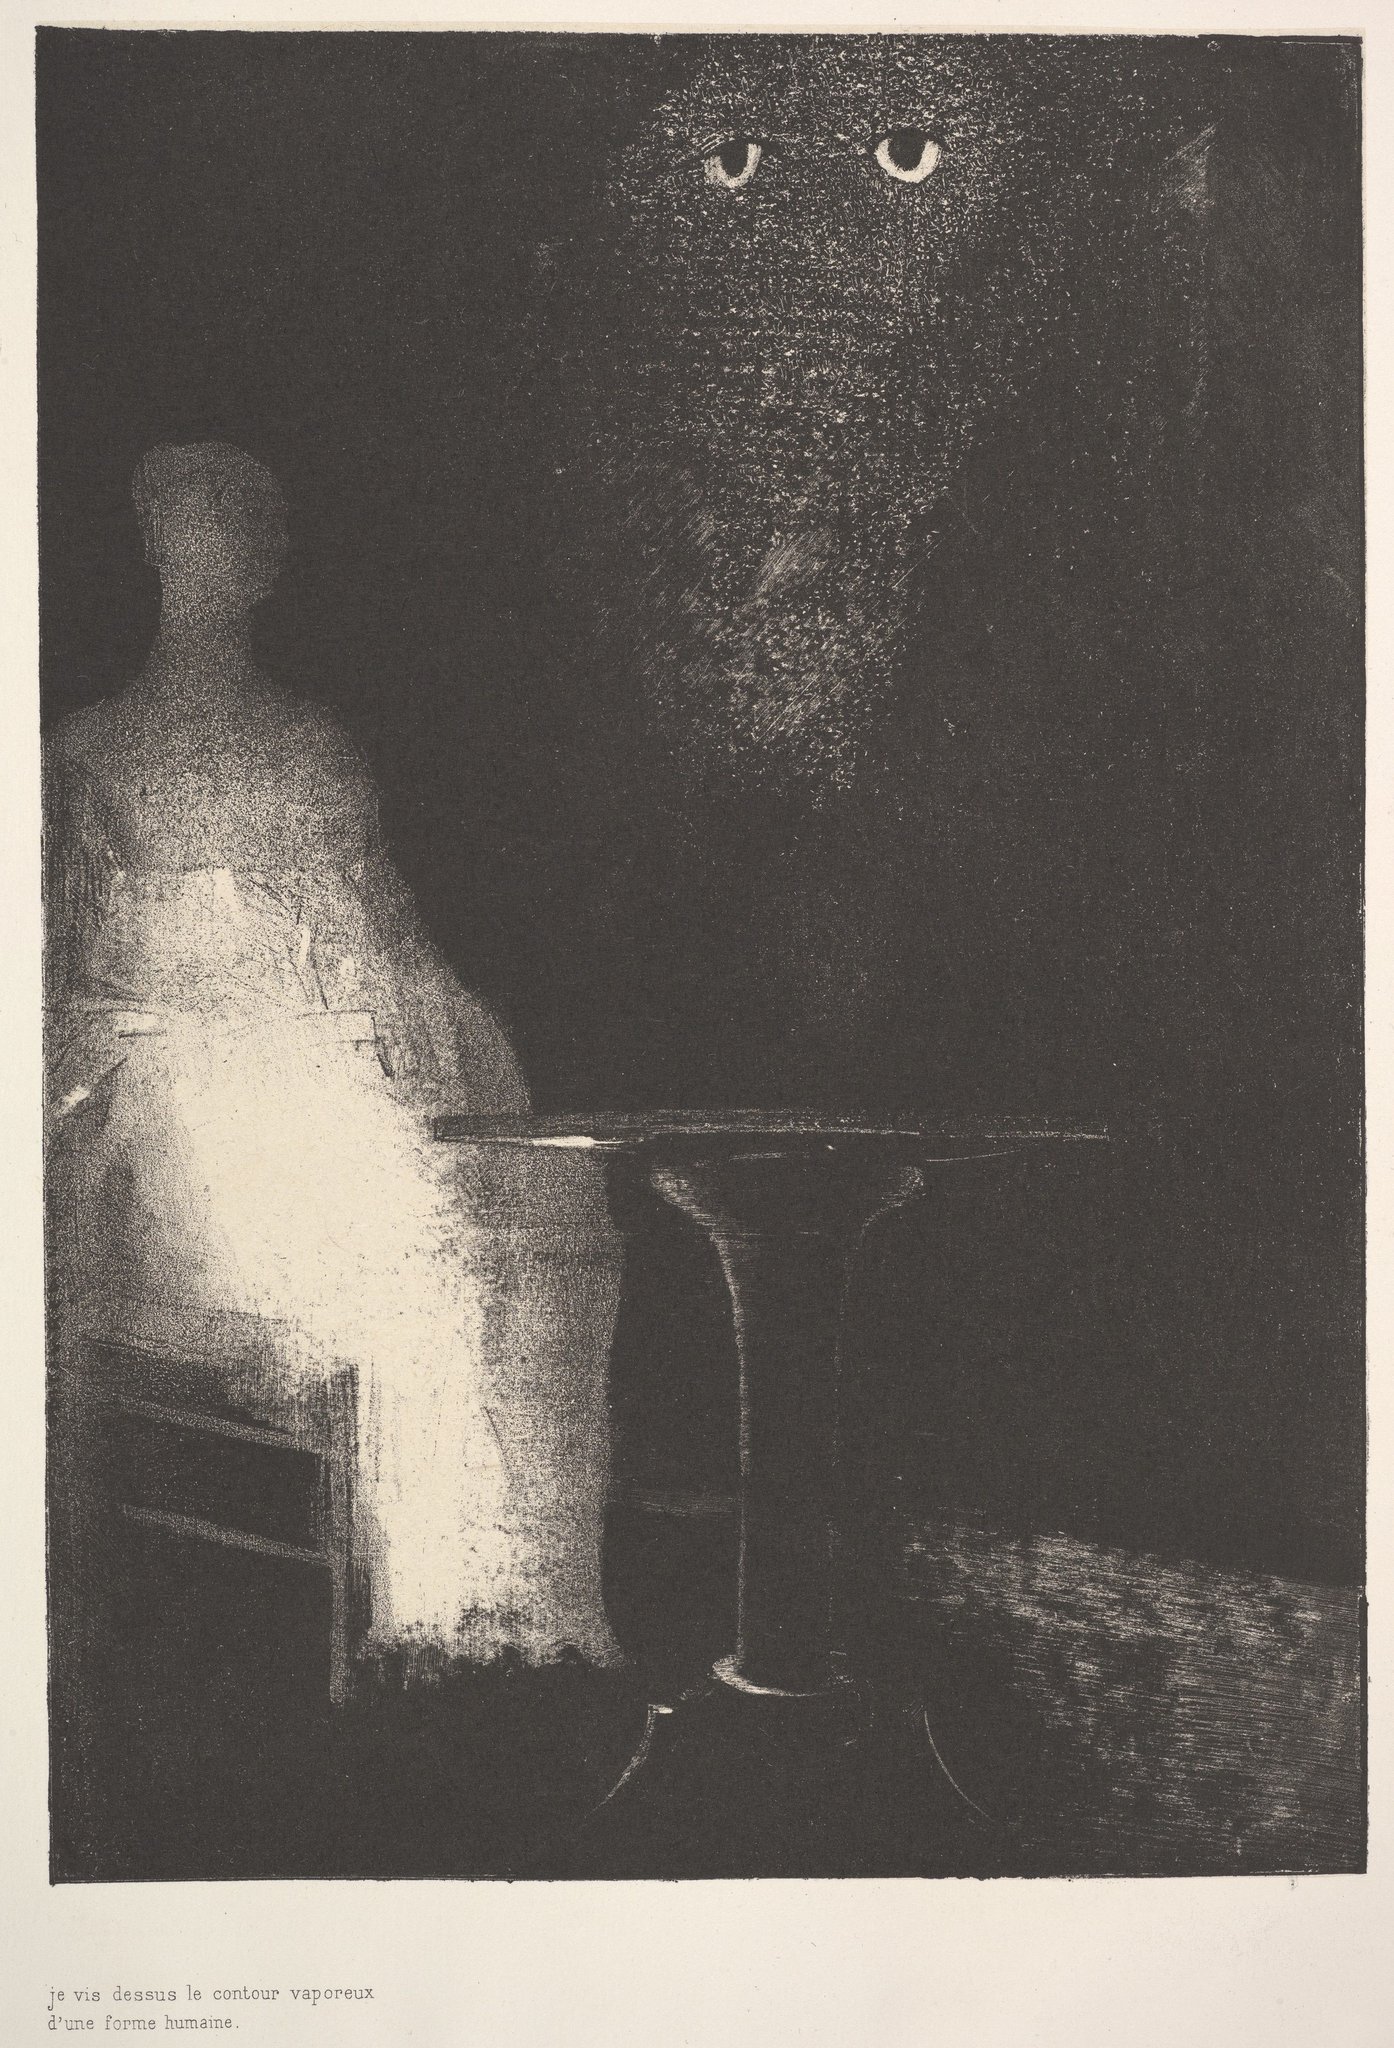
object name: print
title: Below, I saw the vaporous contours of a human form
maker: odilon redon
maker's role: artist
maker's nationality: french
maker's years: 1840-1916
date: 1896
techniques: lithograph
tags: human figures,eyes,tables